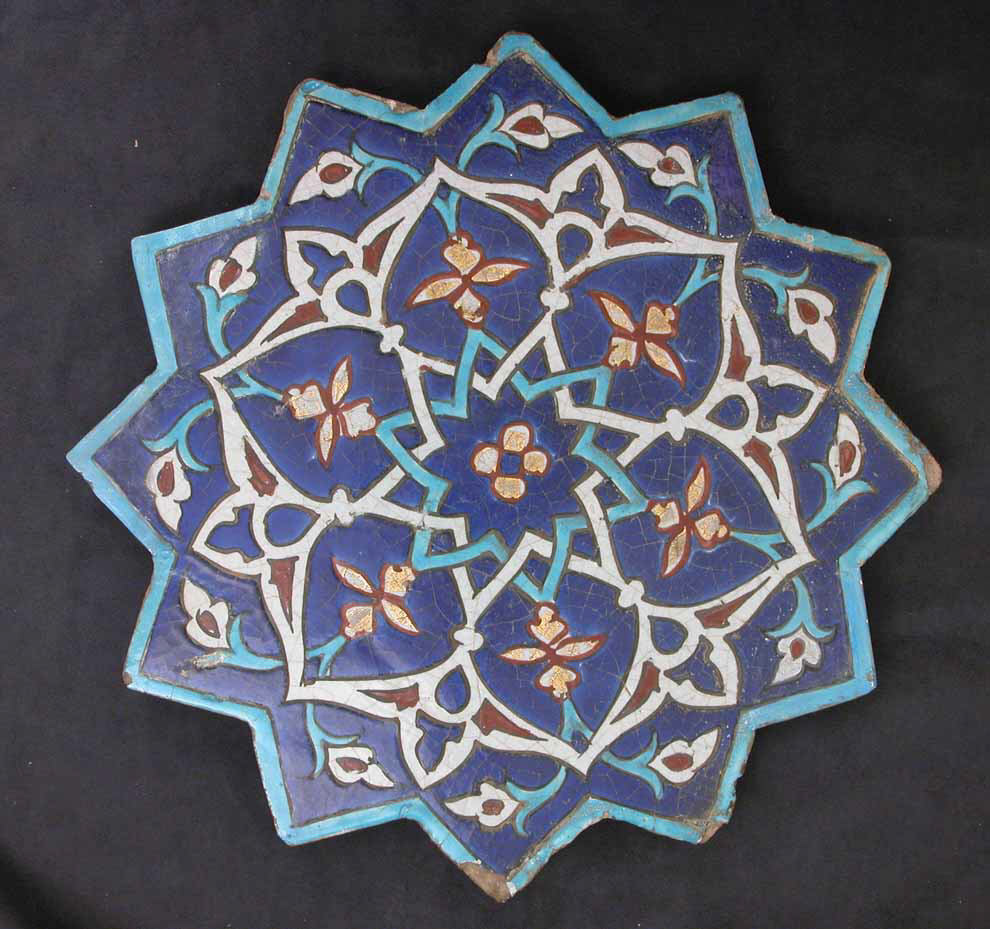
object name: tile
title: Twelve-Pointed Star-Shaped Tile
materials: glaze, stonepaste, wax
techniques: polychrome, resist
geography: iran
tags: stars